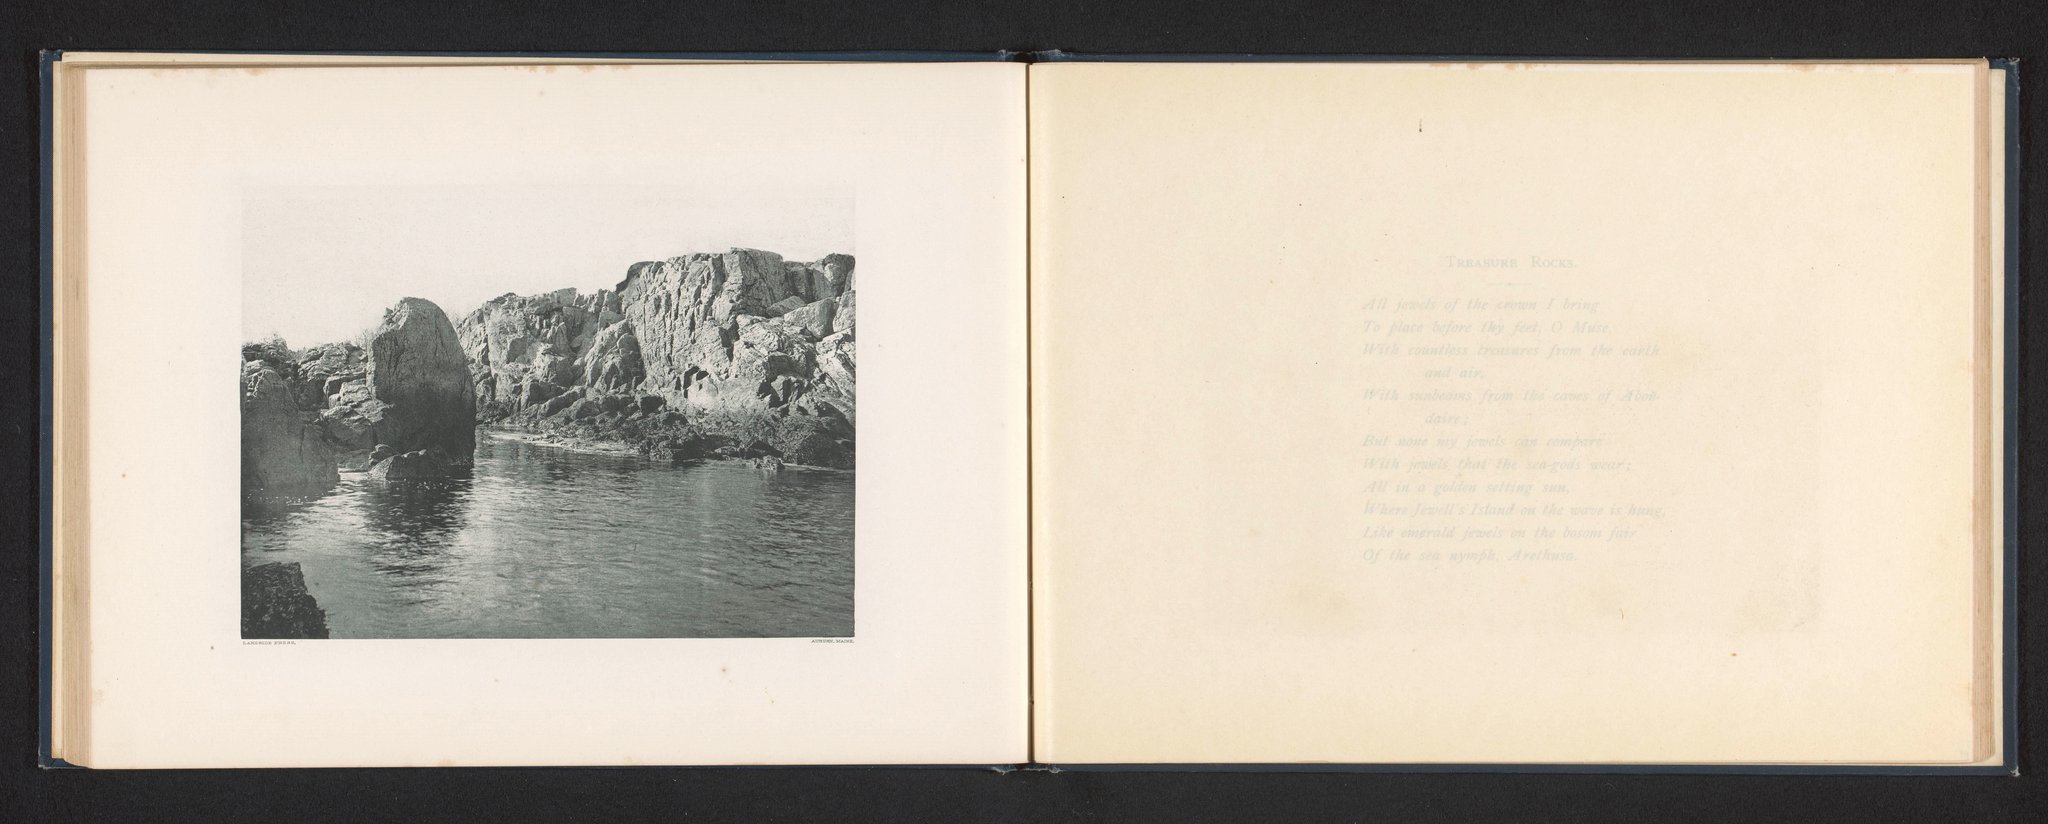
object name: page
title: Gezicht op een rotskust in vermoedelijk Maine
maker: Anonymous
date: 1880-1890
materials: paper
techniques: photoaquatint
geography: maine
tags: rocky coast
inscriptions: inscription: ‘Treasure Rocks. (...)’